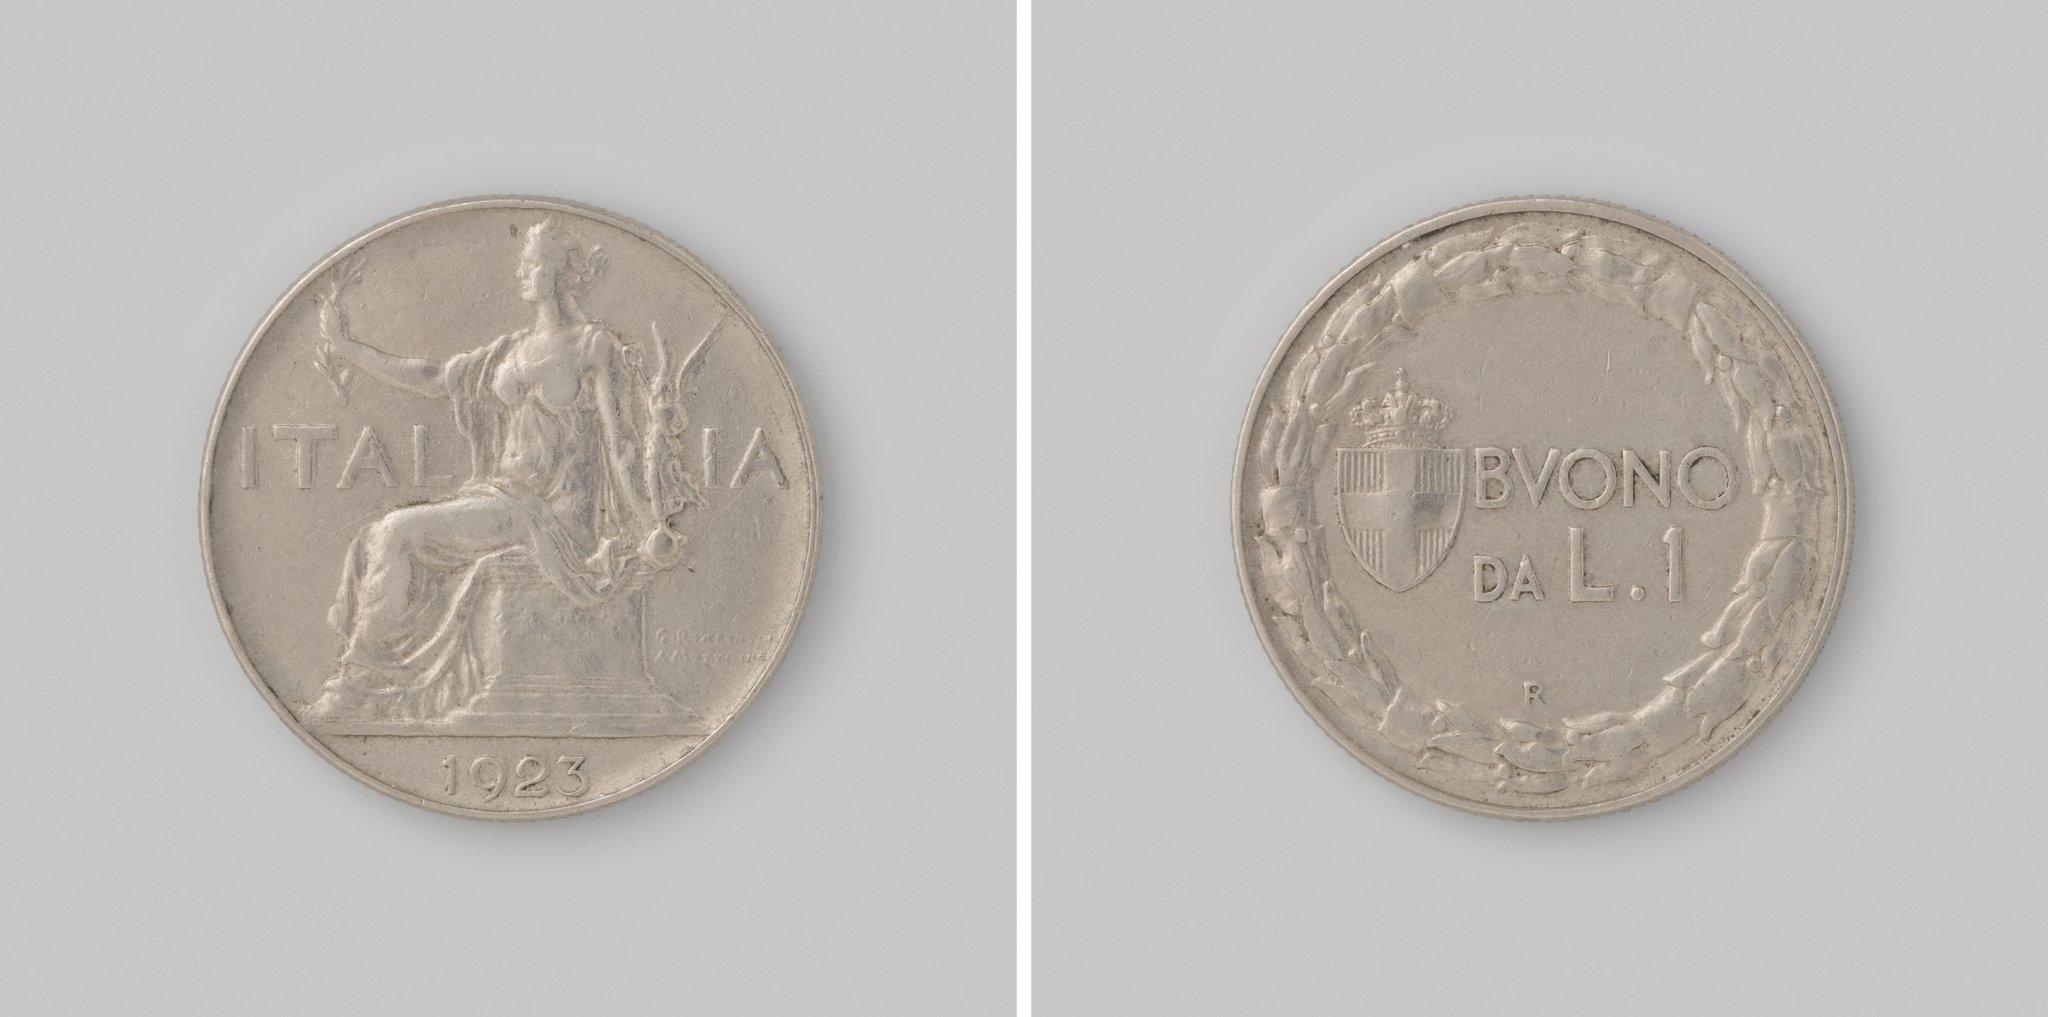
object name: coin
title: Italië, koning Vittorio Emanuele III, lira, 1923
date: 1923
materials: nickel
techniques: striking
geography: rome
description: Nikkelen munt. Voorzijde: vrouw, gezeten op sokkerl, naar links kijkend met in beide handen symbolen. In afsnede jaartal. Keerzijde: binnen krans gekroond wapenschild van Italië met rechts daarvan in twee regels waarde-aanduiding: bvono da L.1. Onderaan muntteken: letter R [=Rome]. Kartelrand.